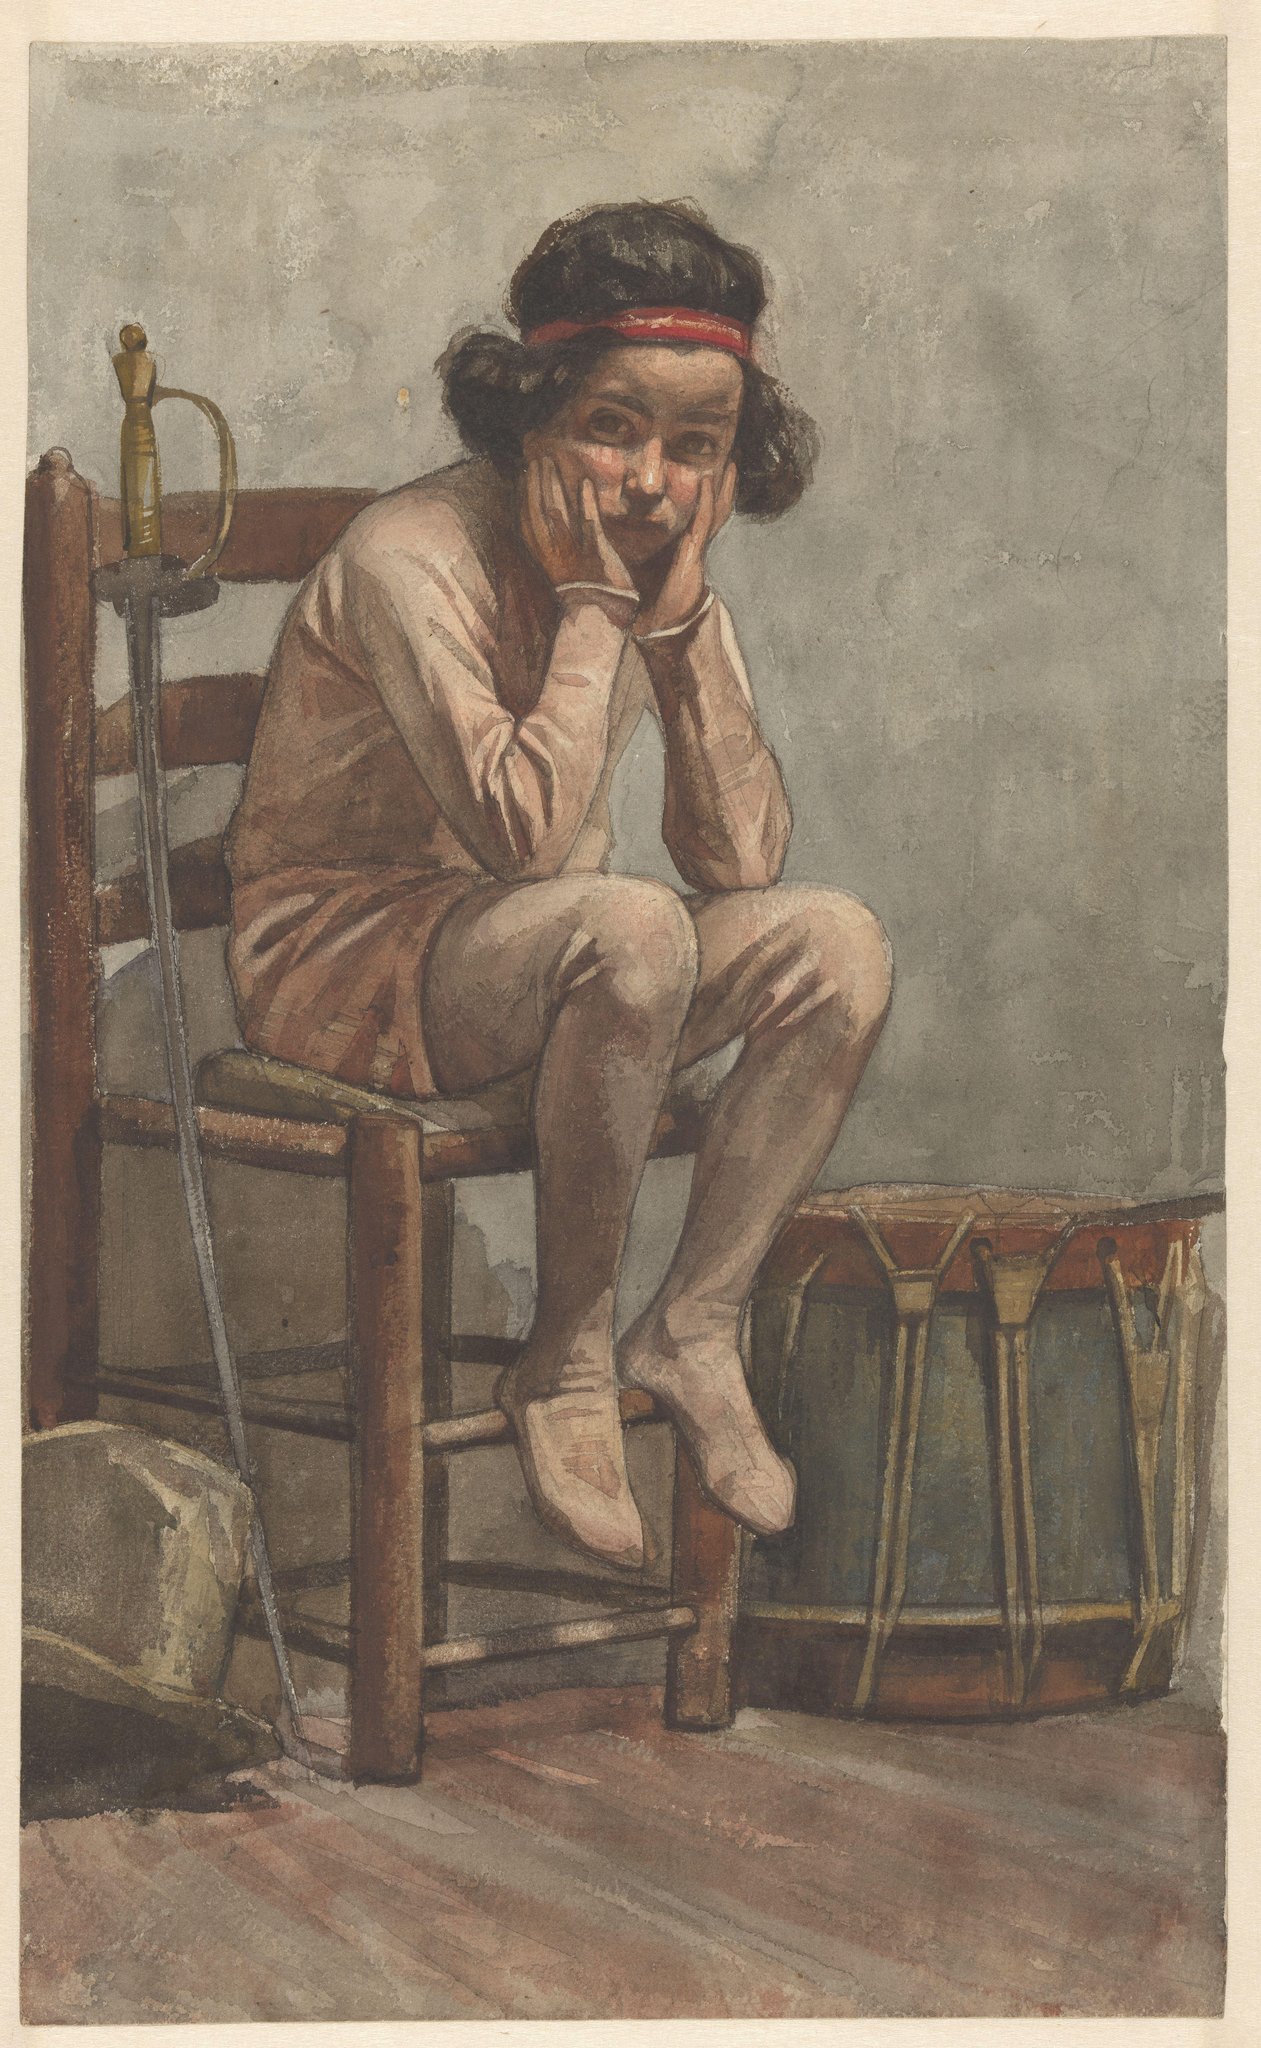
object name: watercolor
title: Zittend meisje in balletpak tussen militaire rekwisieten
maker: willem witsen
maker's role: draughtsman, painter, print maker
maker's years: 1860-1923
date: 1870-1923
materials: paper, pencil, watercolor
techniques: brush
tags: hacking and thrusting weapons: sword, girl (child between toddler and youth), drum (musical instrument), head-gear: hat, chair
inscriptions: number: ‘T126’